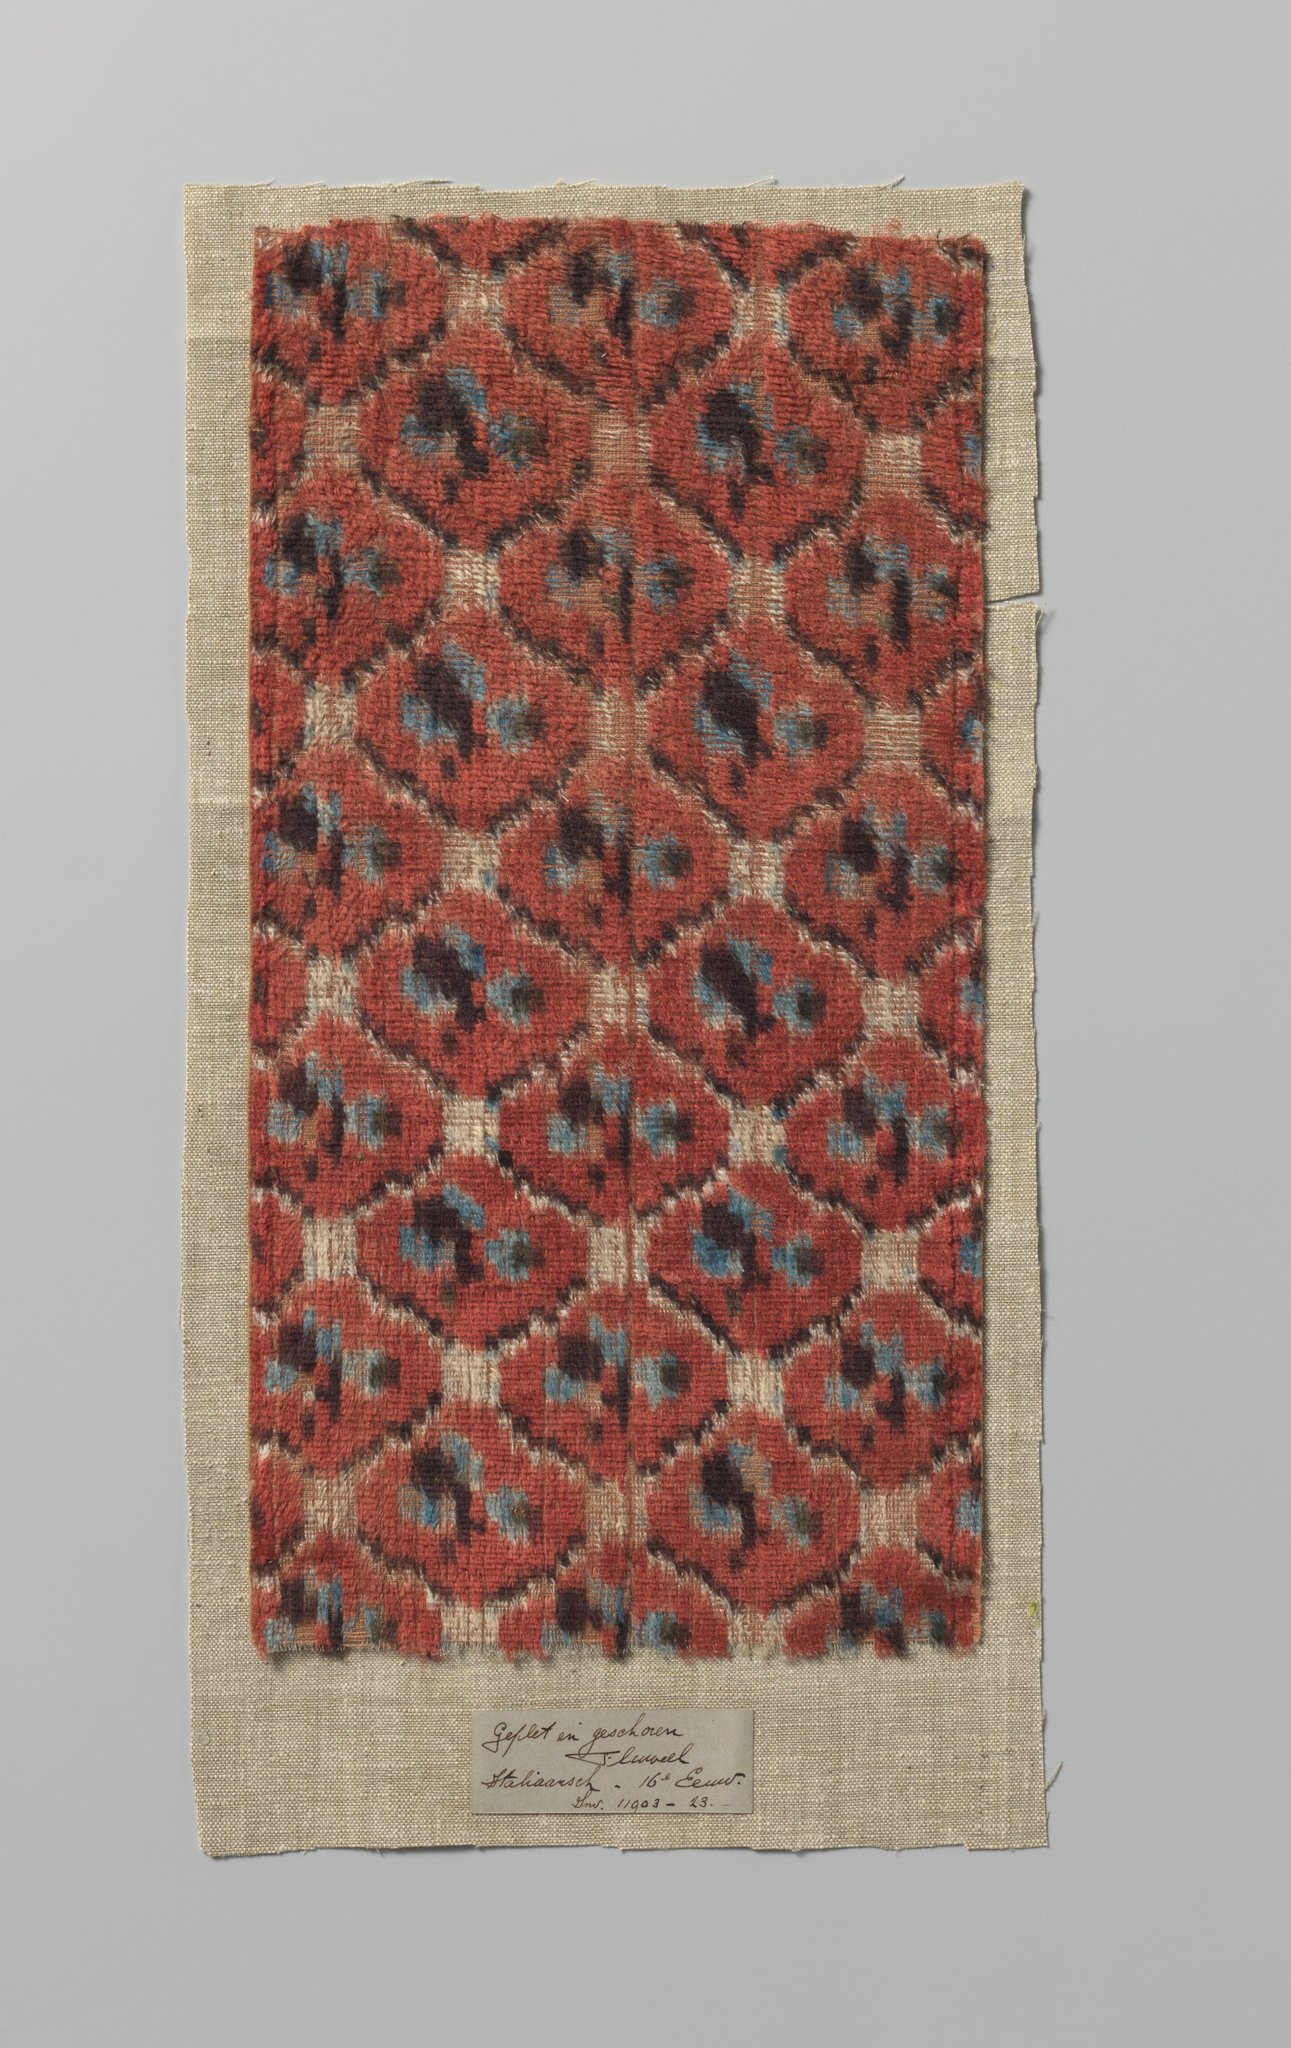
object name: zijdefluweel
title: Fragment veelkleurig zijdefluweel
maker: Anonymous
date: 1500-1599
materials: cotton, silk, velvet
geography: italy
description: Fragment zijdefluweel met op lichte fond een bedrukt patroon van in ongelijke rijen geplaatste rode zeshoeken gevuld met zwart- en groengekleurde bloemen. Italië, 16de eeuw.